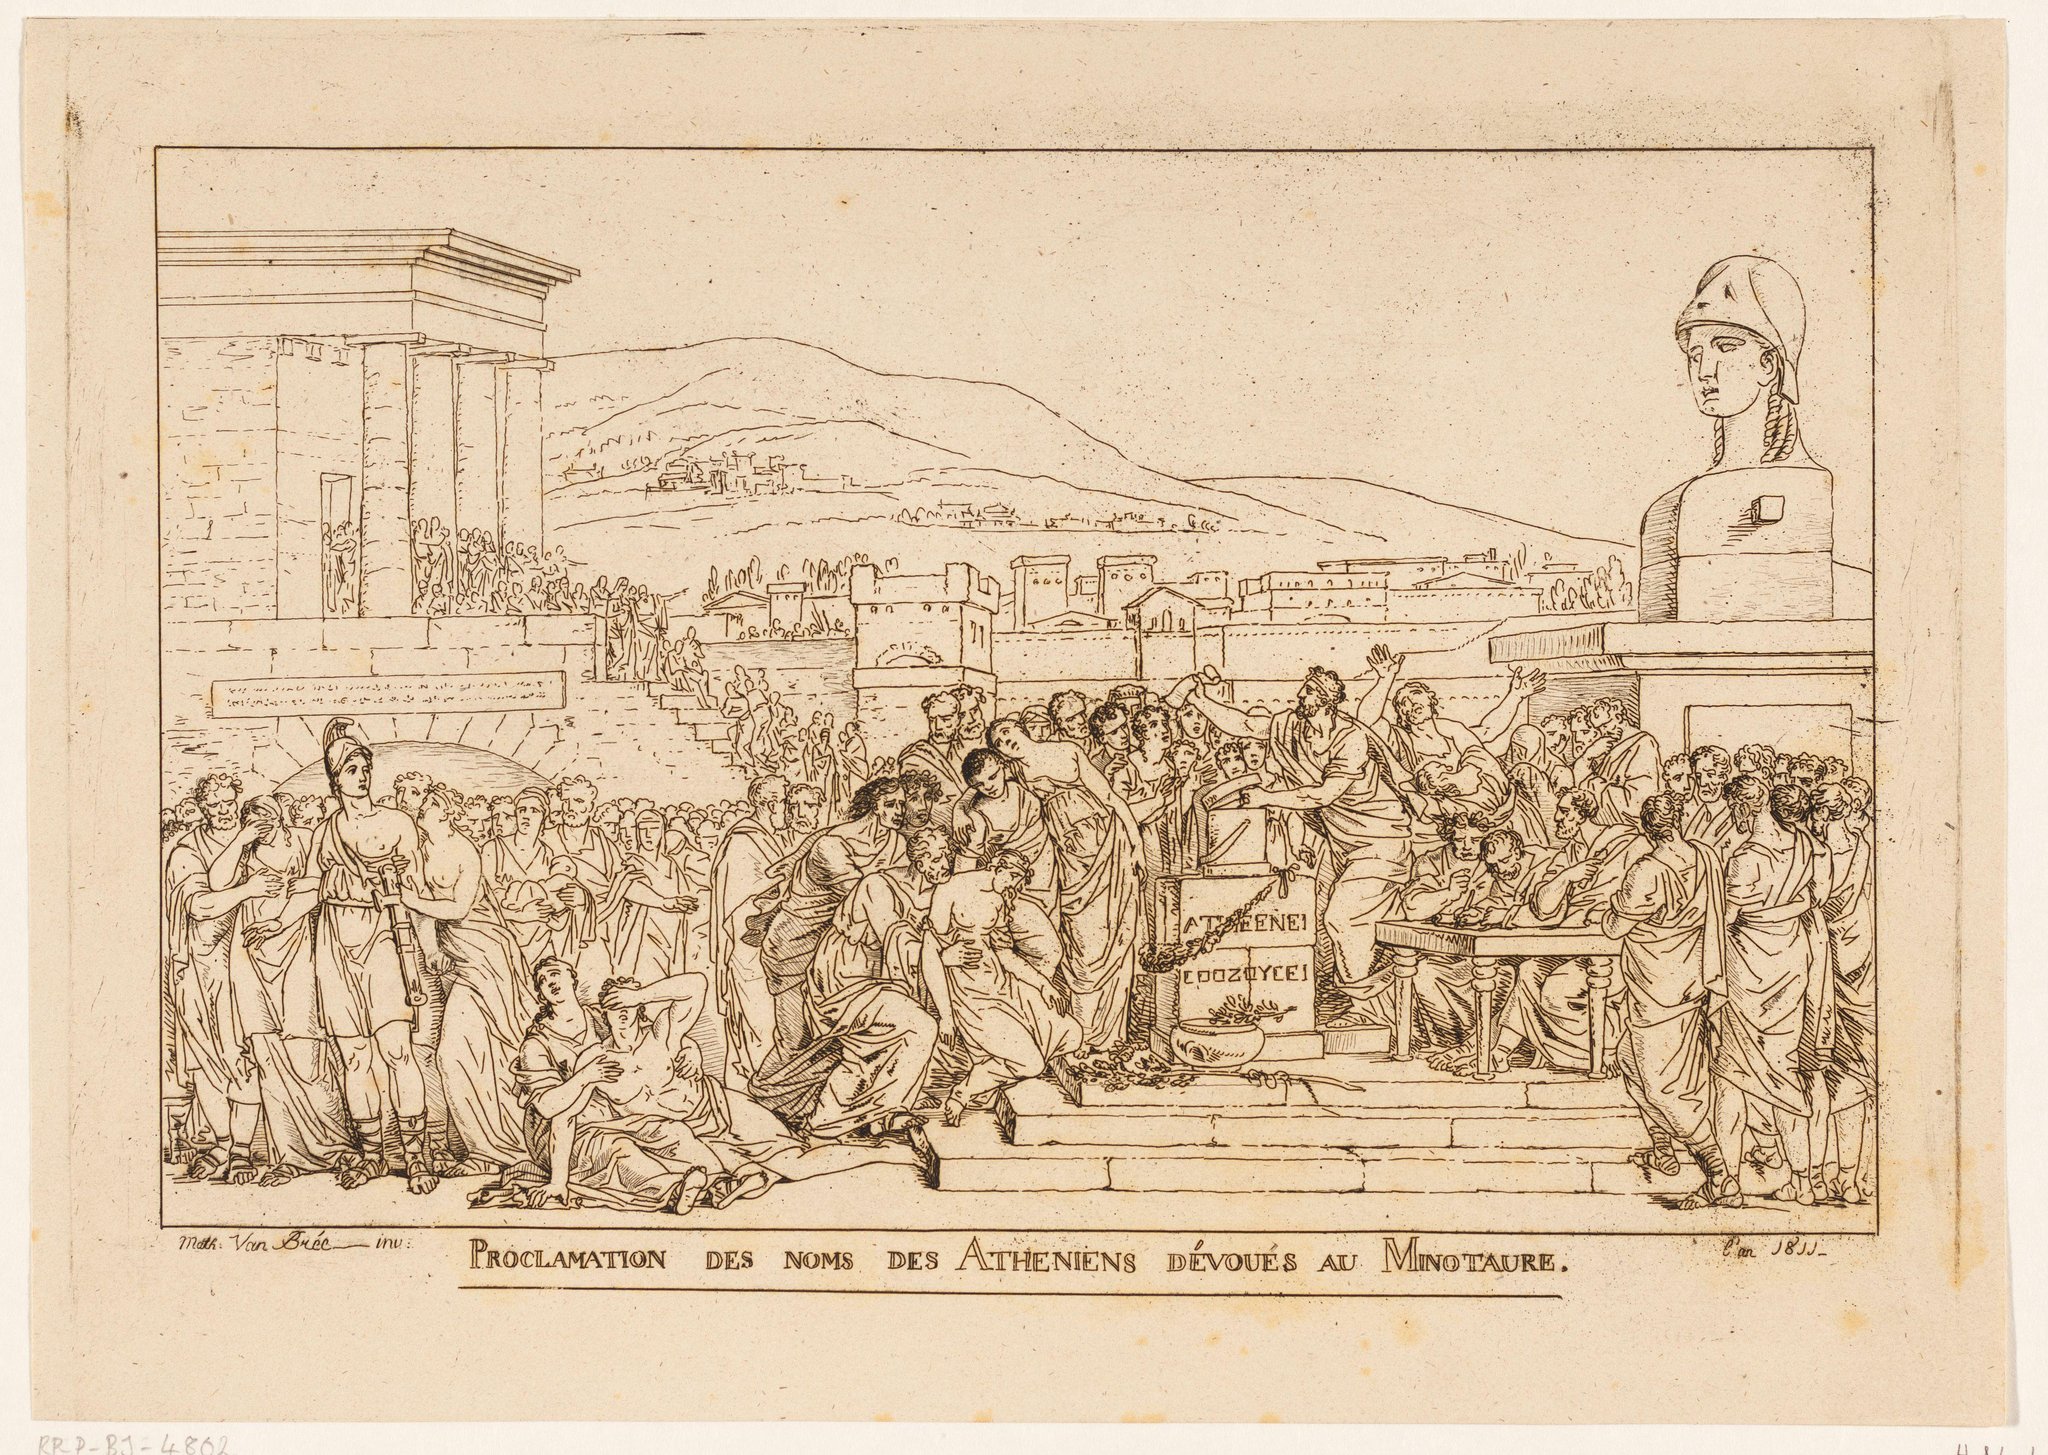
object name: print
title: Proclamation des noms des Atheniens dévoués au Minotaure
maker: mattheus ignatius van bree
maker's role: draughtsman, print maker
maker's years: 1773-1839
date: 1811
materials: paper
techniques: drypoint, etching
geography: antwerp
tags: the athenian youths draw lots for the yearly tribute to crete: seven youths and seven maidens to be devoured by the minotaur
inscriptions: collector's mark: Lugt 2228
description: Op een groot plein in Athene is een grote groep mensen bijeen. Op een verhoging staat een urn waaruit het orakel de namen van de Atheense jongeren bepaalt die aan het monster Minotaurus geofferd moeten worden. Links staat de Griekse held Theseus die het monster uiteindelijk zal doden en de Atheners zal verlossen van de last.